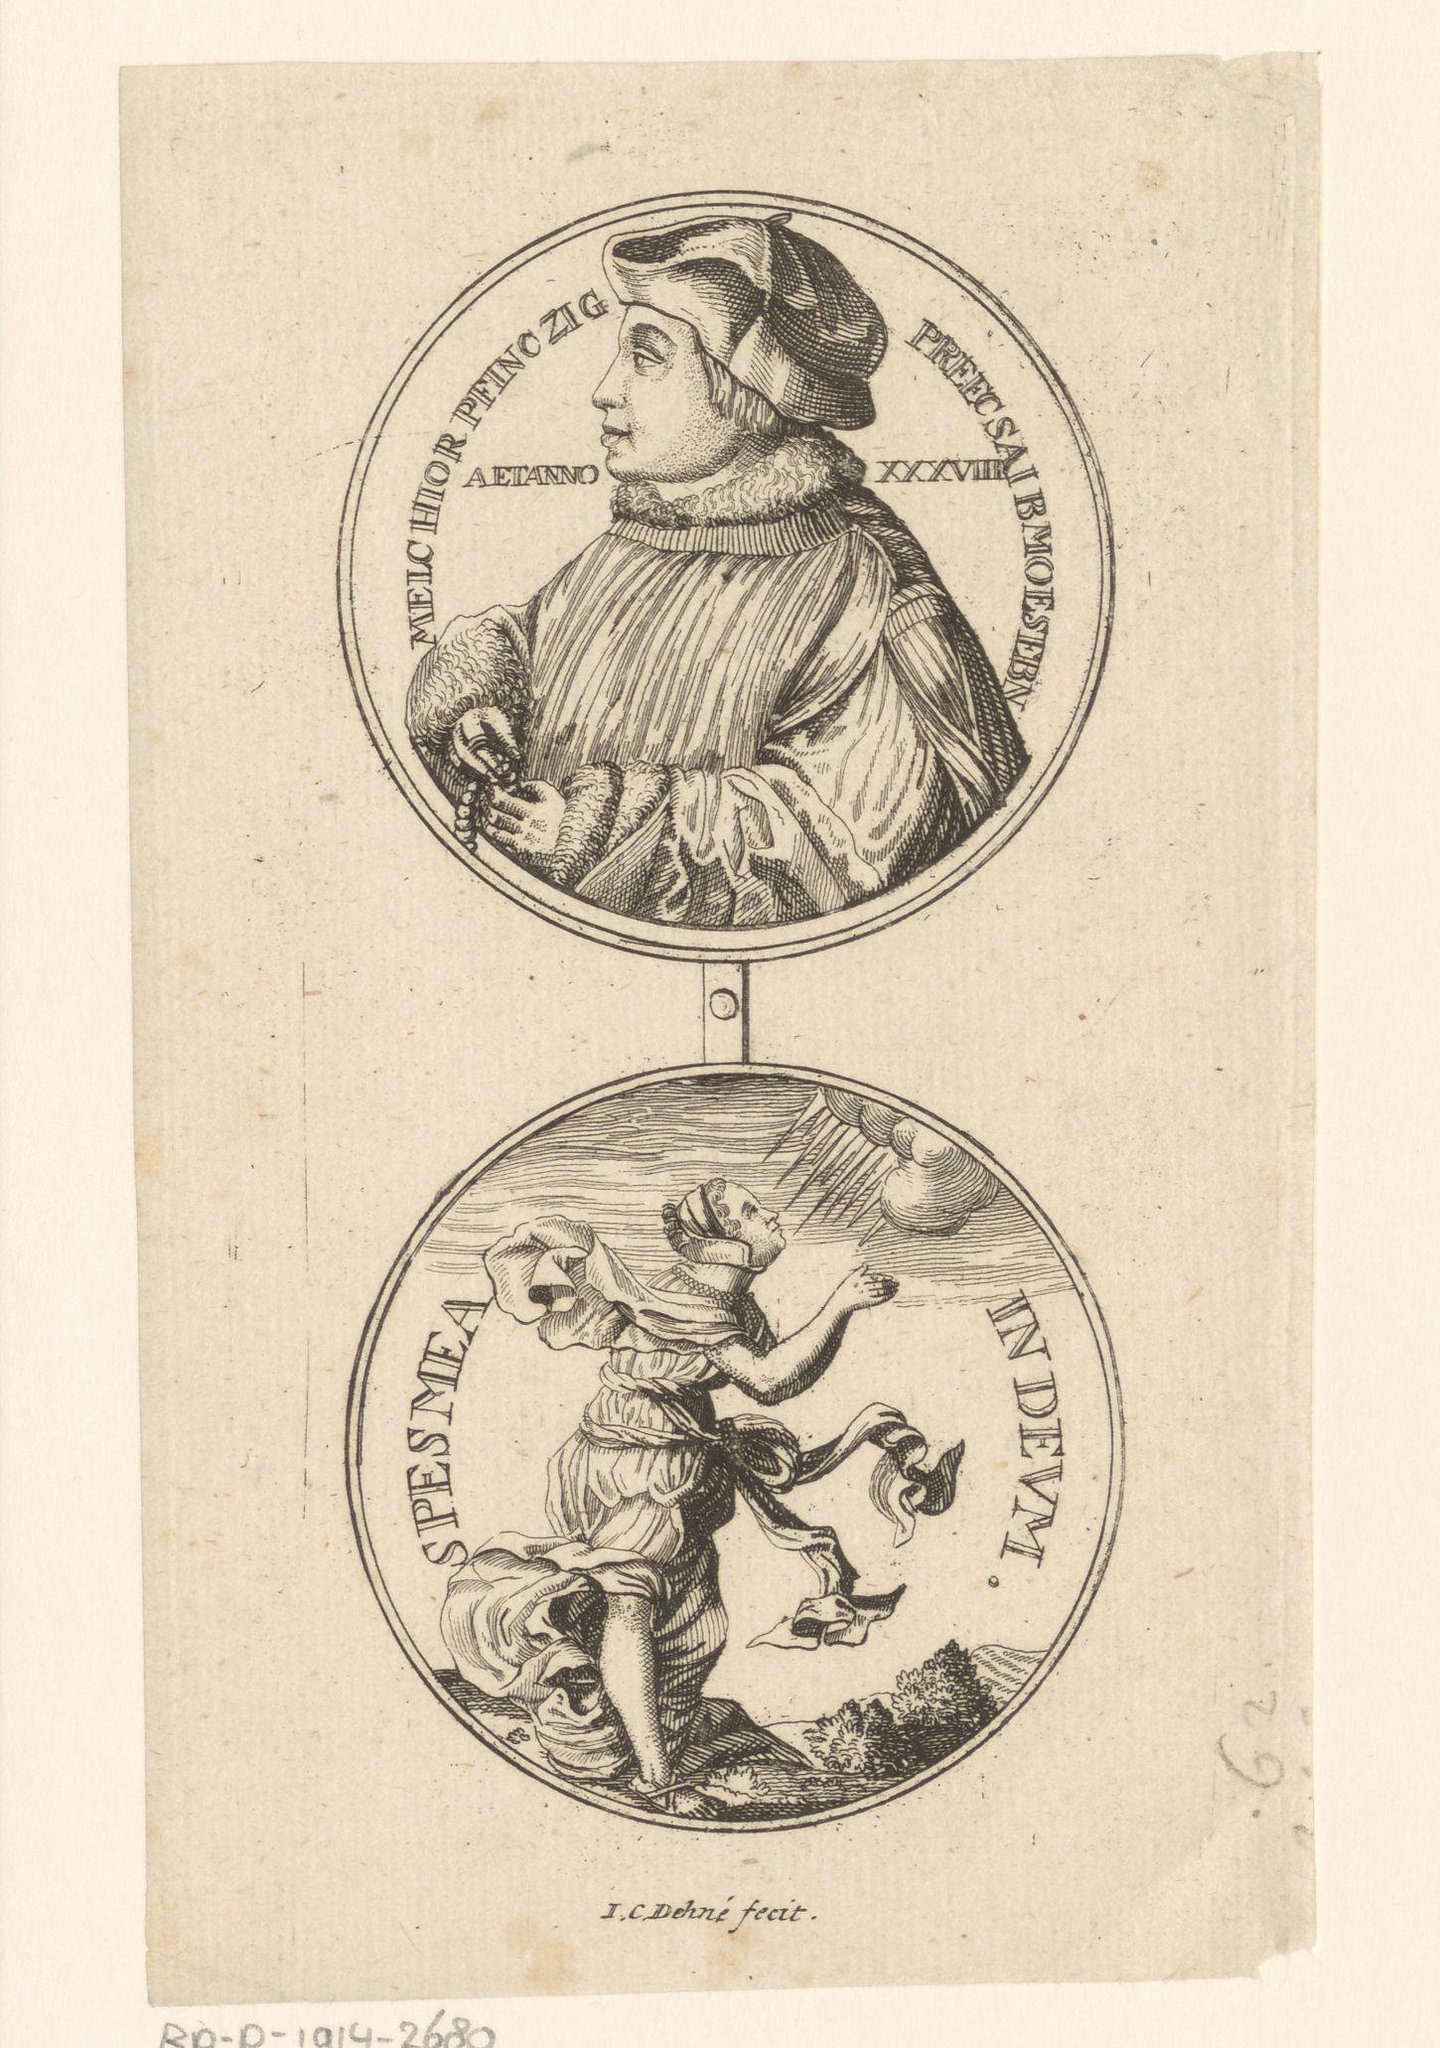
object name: print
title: Medaillon met het portret van Melchior Pfinczig op 38-jarige leeftijd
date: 1714-1726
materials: paper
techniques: etching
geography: leipzig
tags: melchior pfinzing, aids for prayer, e.g. rosary, historical persons, coin, light shining out of the heavens, one person praying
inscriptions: collector's mark: Lugt 2228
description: Prent uit: Titz, Heinrich Gottlieb. Disquisitio de inclyto libro poetico Theuerdanck (...). Altdorf: Magnus Daniel Meyer, 1714.